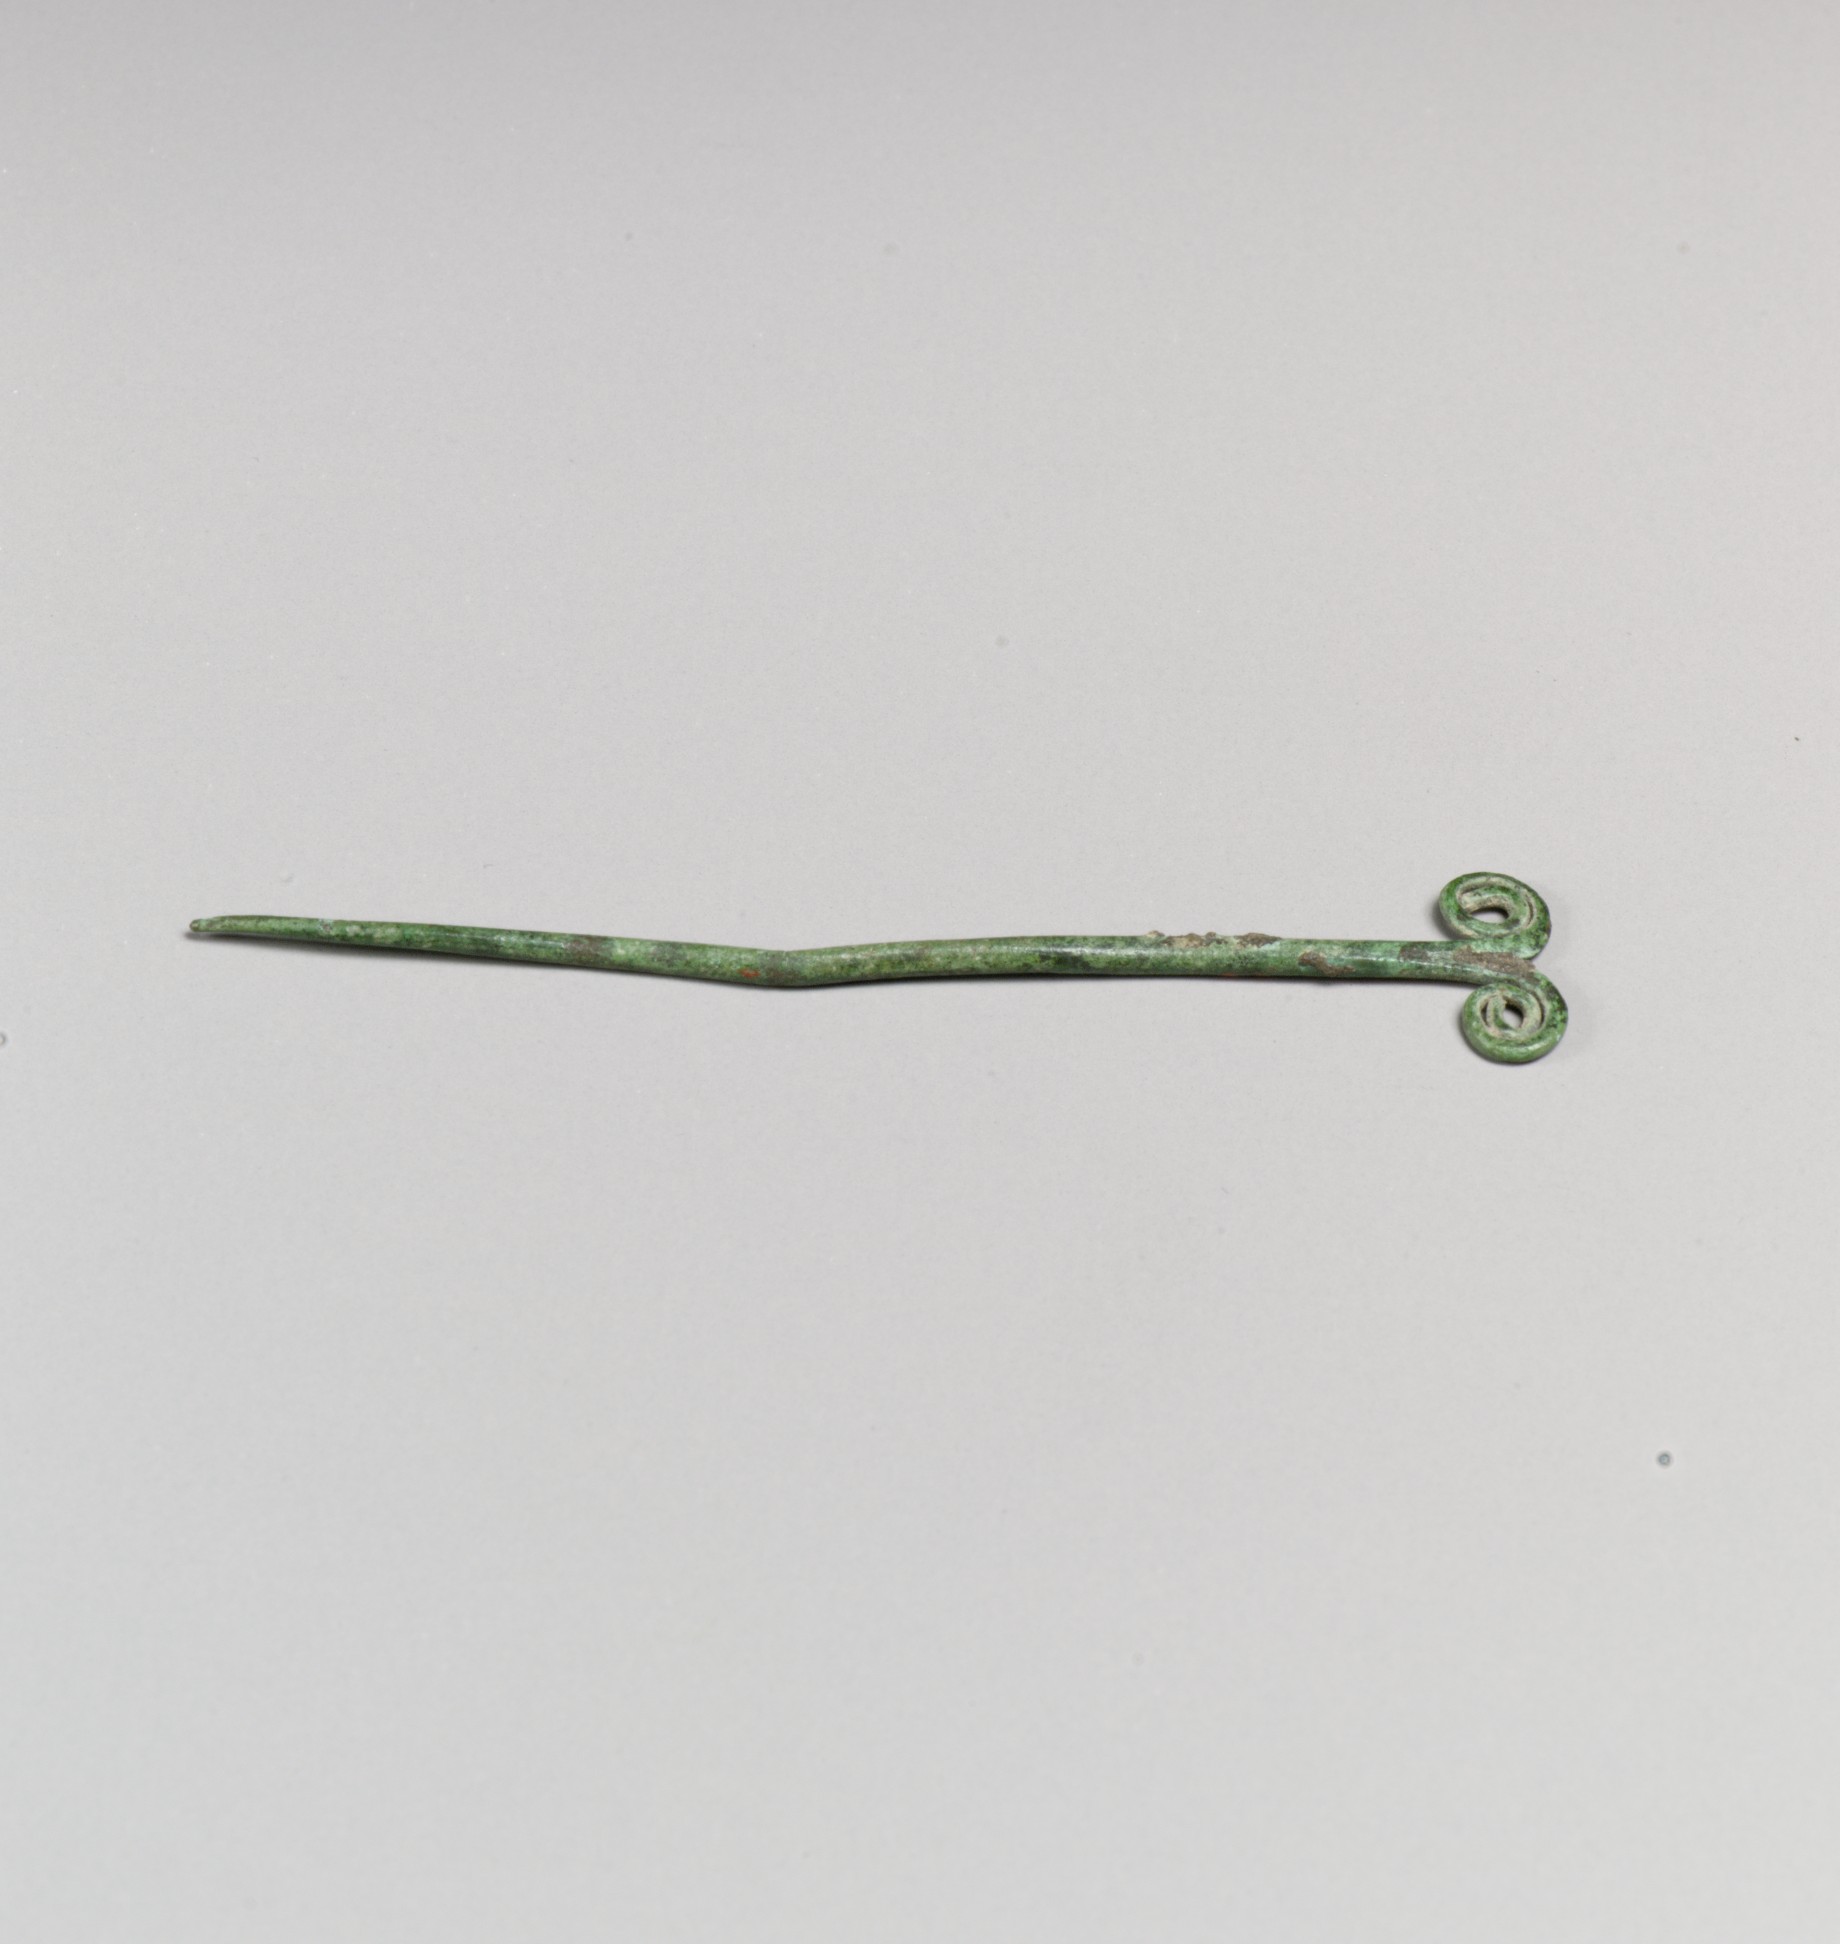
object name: pin with spiral head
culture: roman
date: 670 BCE-330 CE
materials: bronze